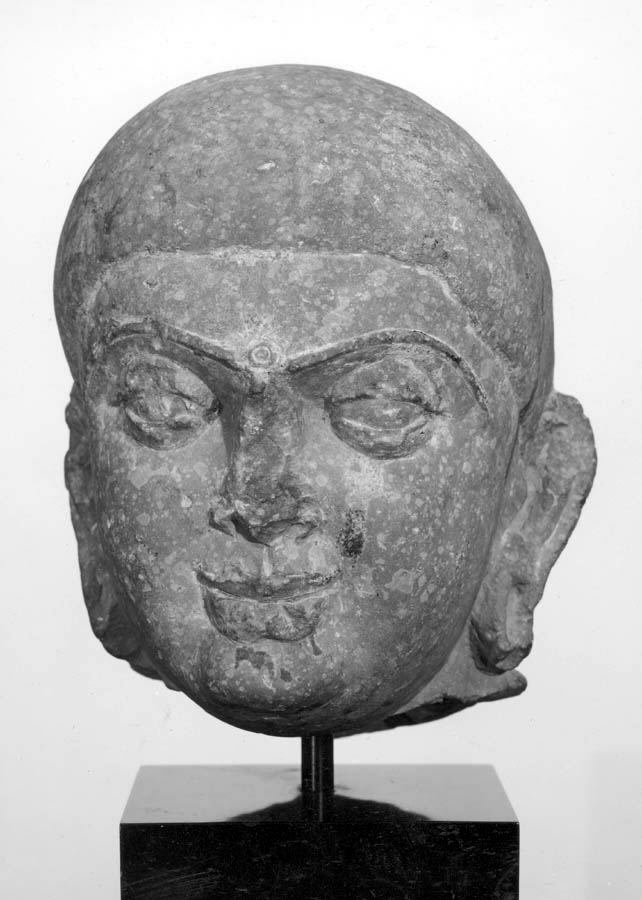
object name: head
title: Head of a Jain Tirthankara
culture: indian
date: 101-200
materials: stone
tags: kushan,mathura,heads